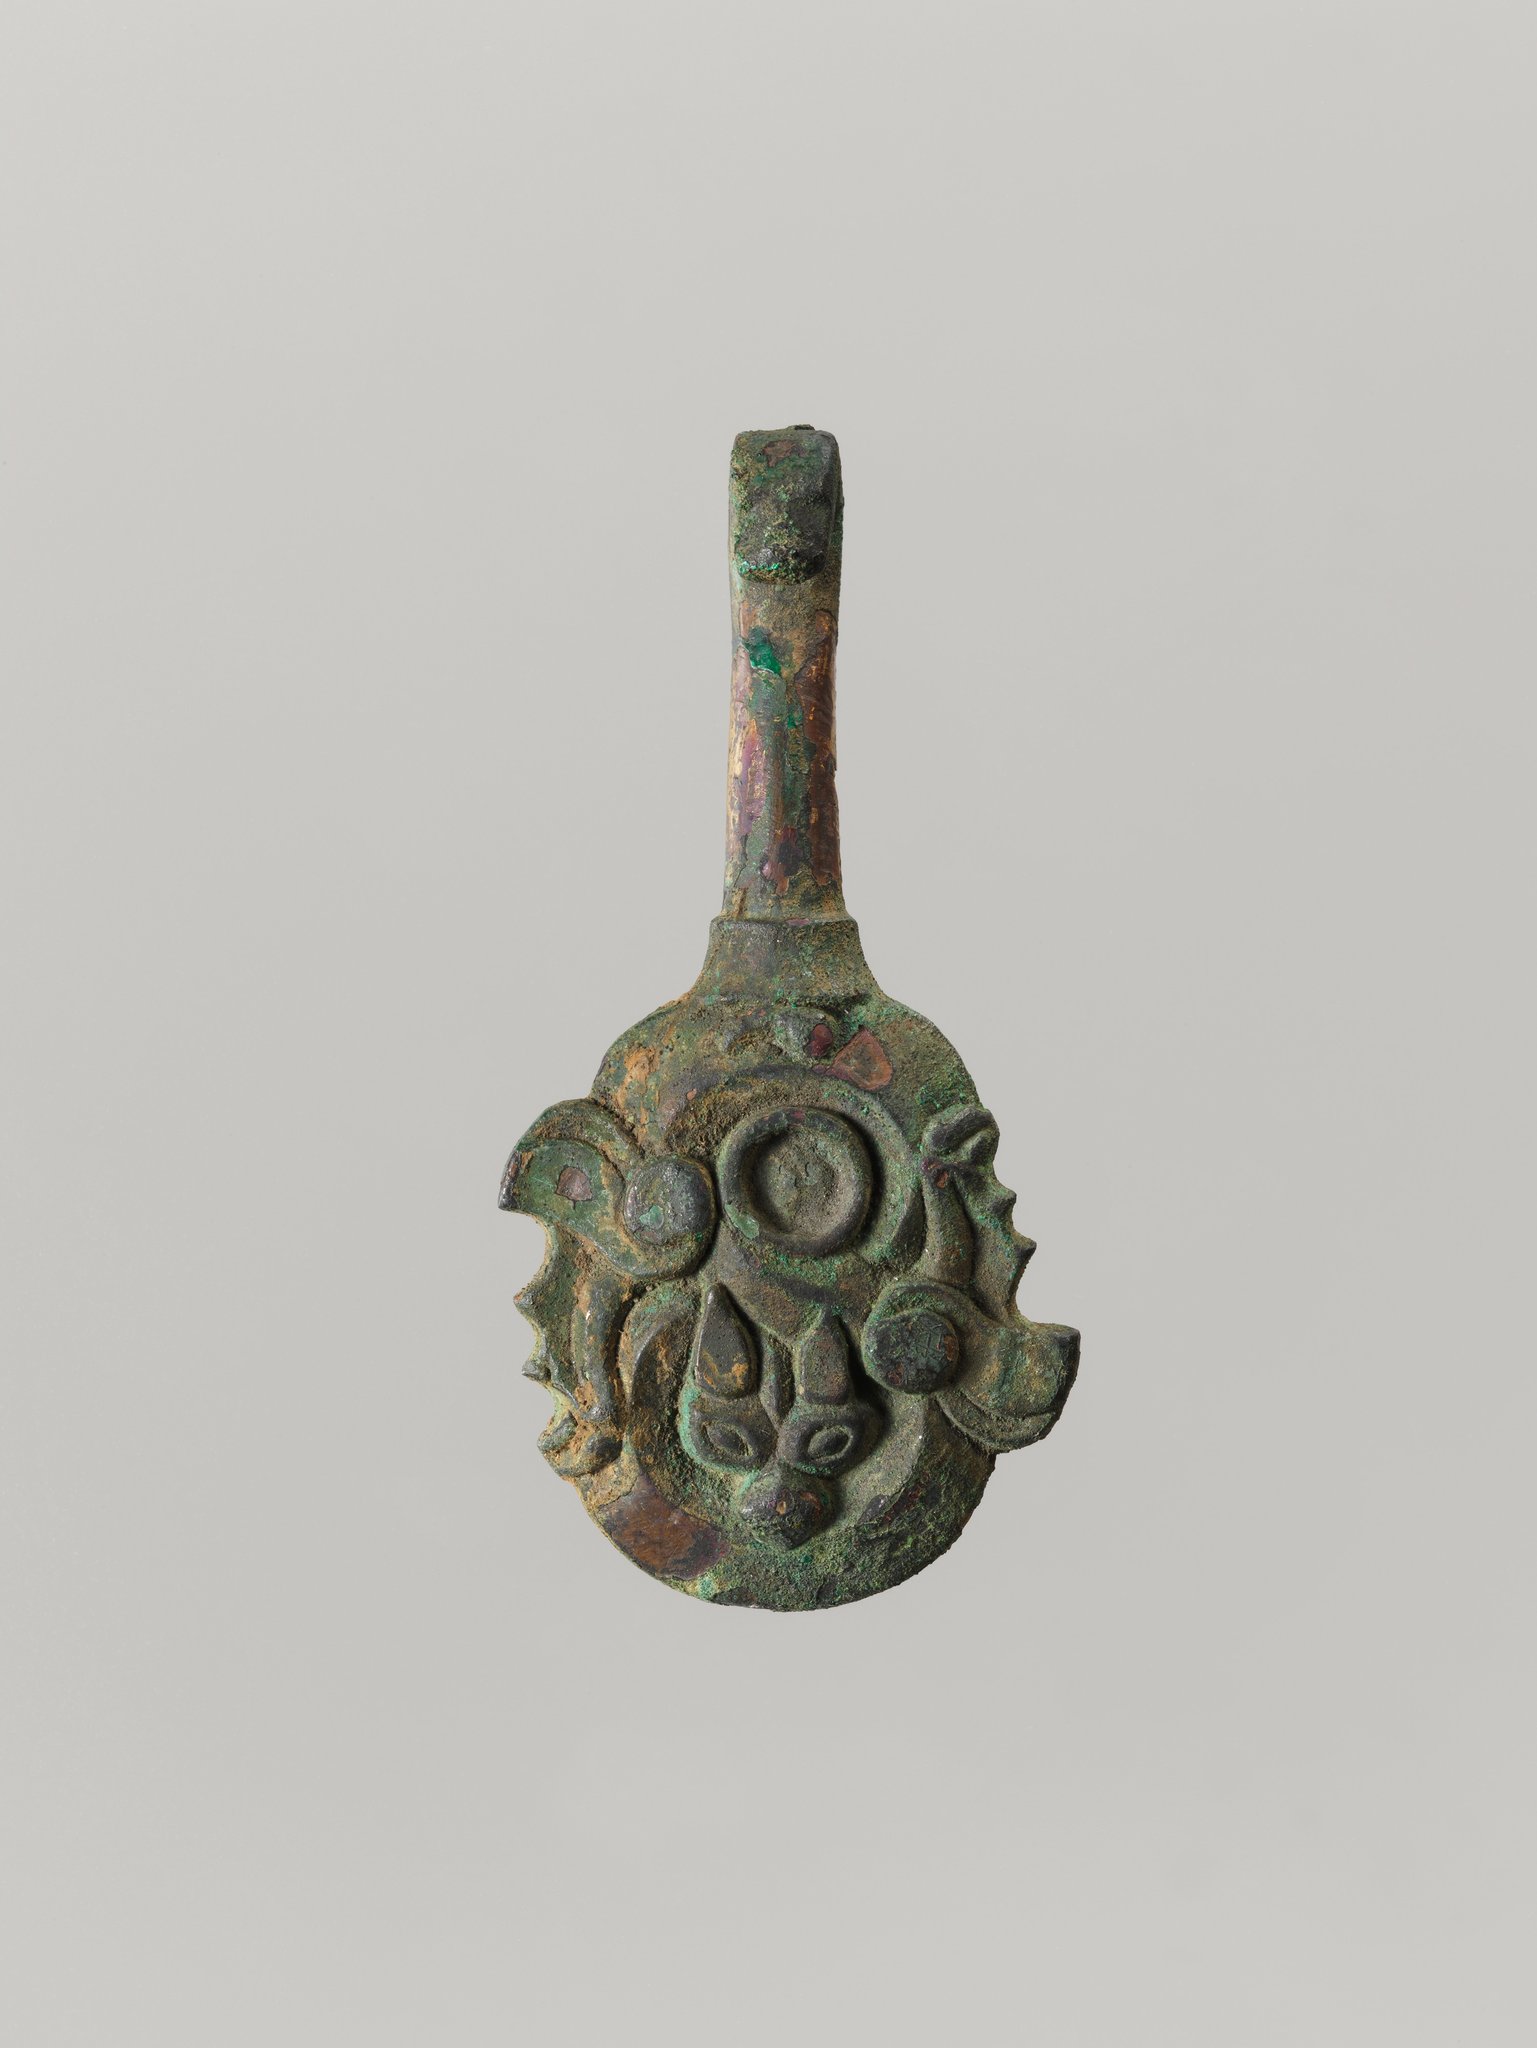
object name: belt hook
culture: chinese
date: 400-201 BCE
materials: bronze